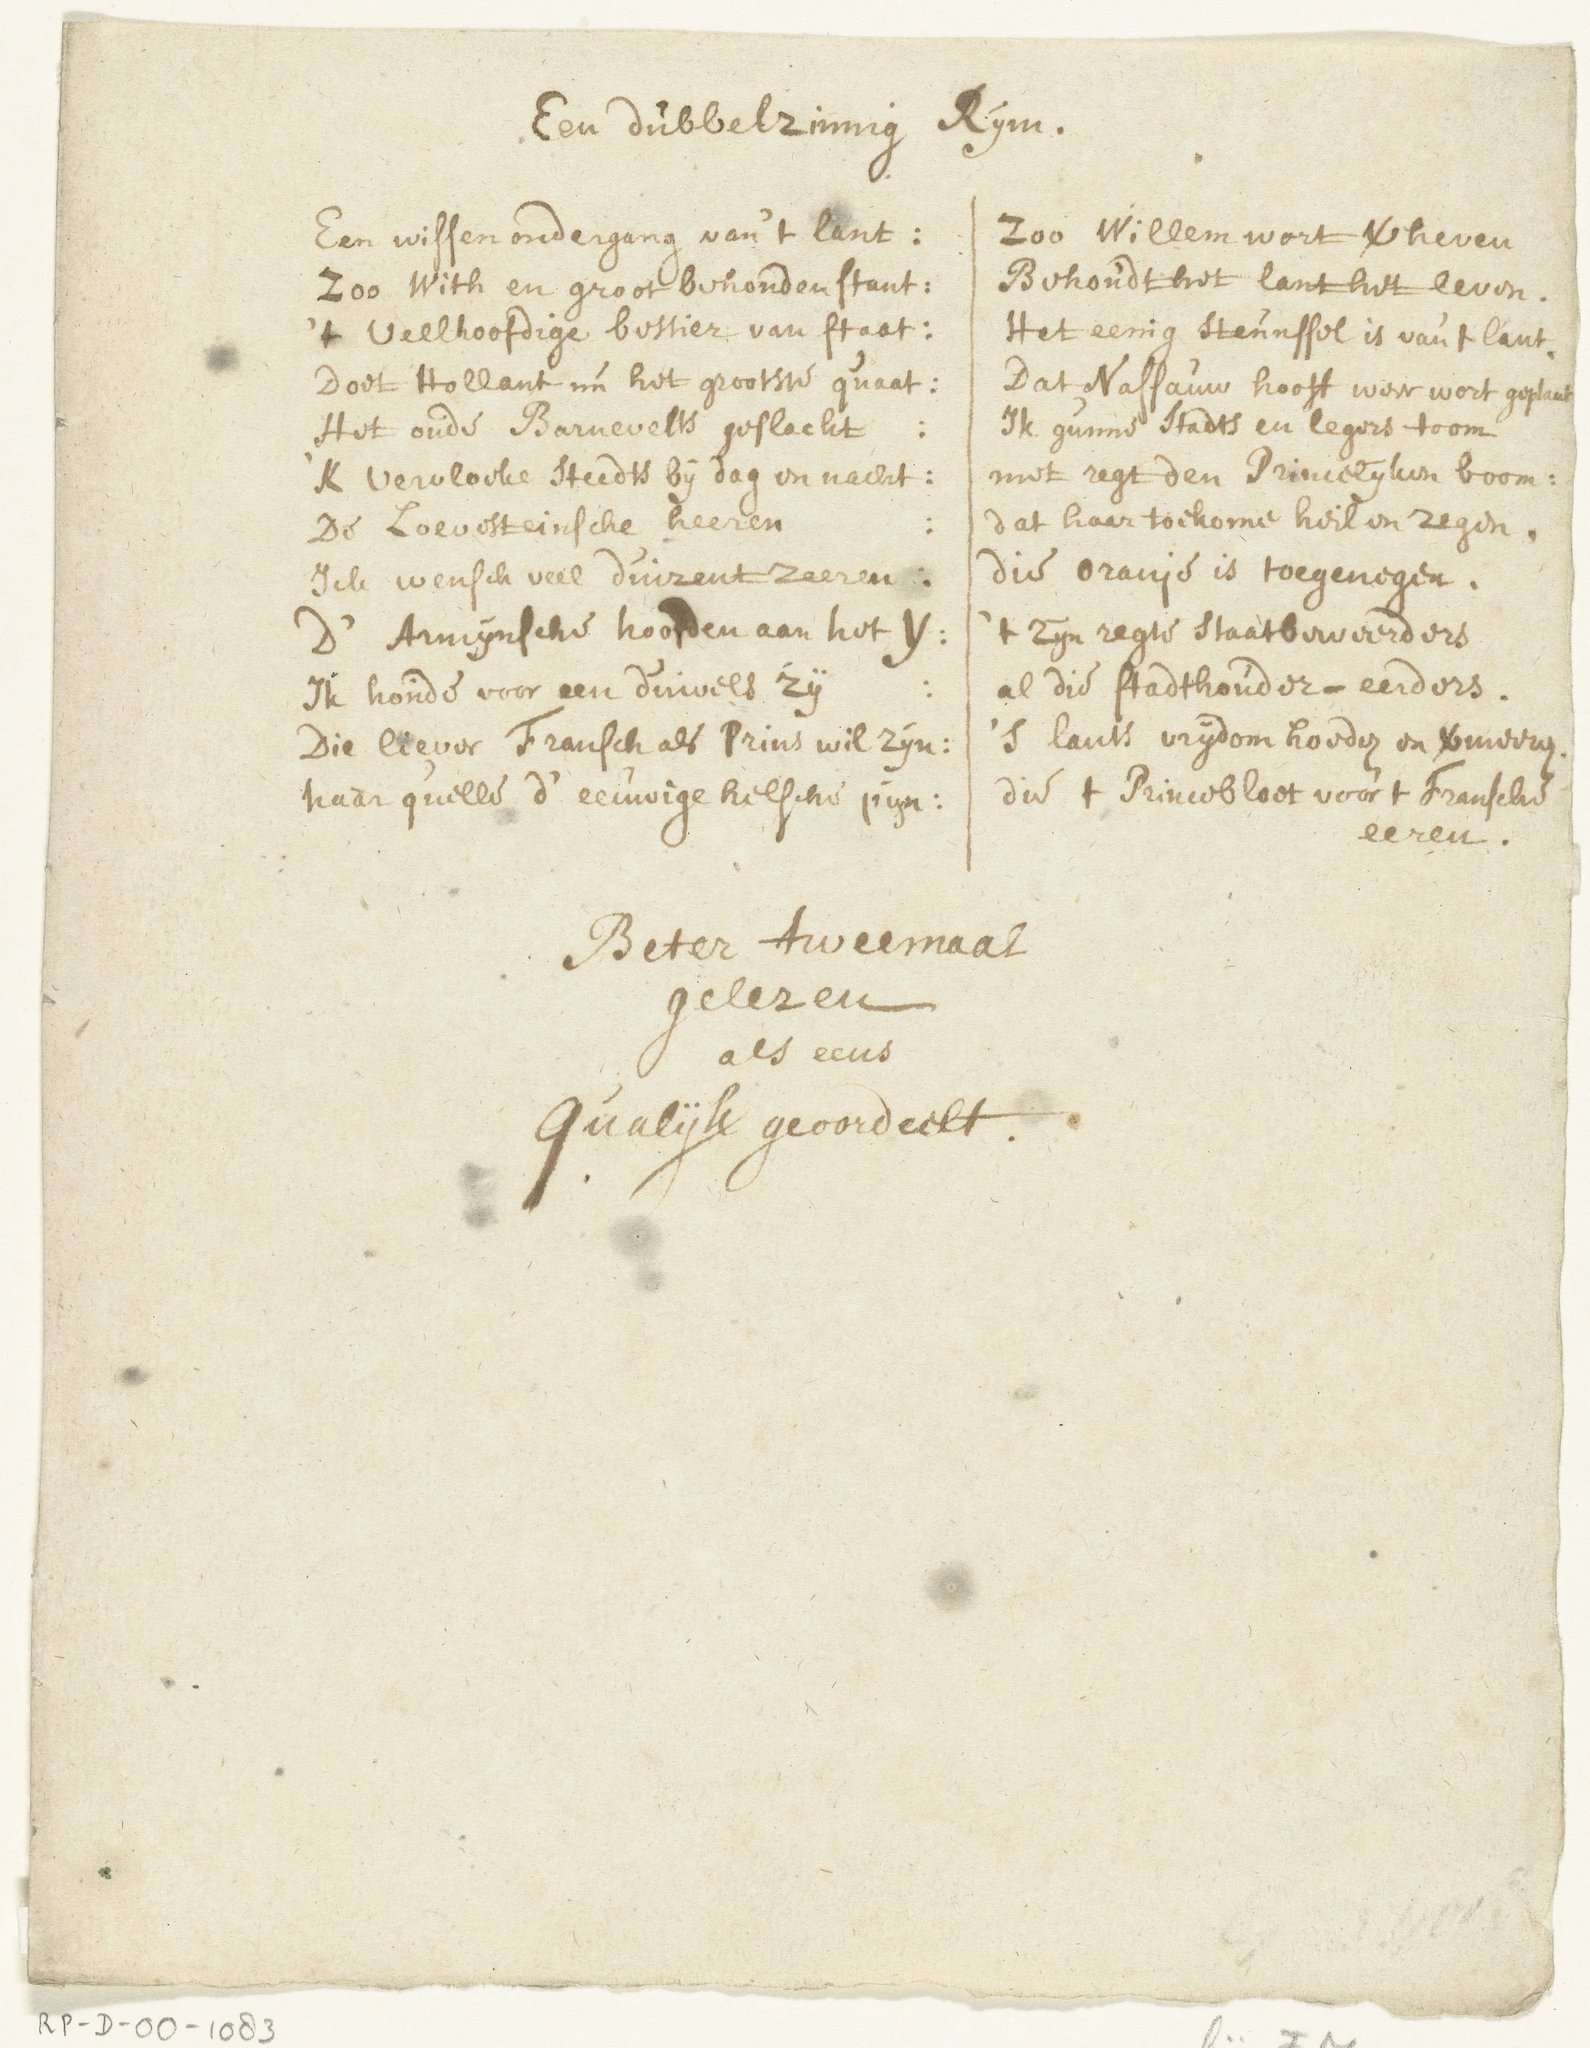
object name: document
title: Vers op de dood van de gebroeders De Witt, 1672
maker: Anonymous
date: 1672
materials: paper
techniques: writing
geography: northern netherlands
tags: dordrecht, cornelis de witt, politician, johan de witt, the hague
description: Vers op de dood van de gebroeders De Witt, 20 augutsus 1672. Vers in twee kolommen waarbij het anti-Orangistische sentiment pas blijkt in het lezen van de tweede kolom.